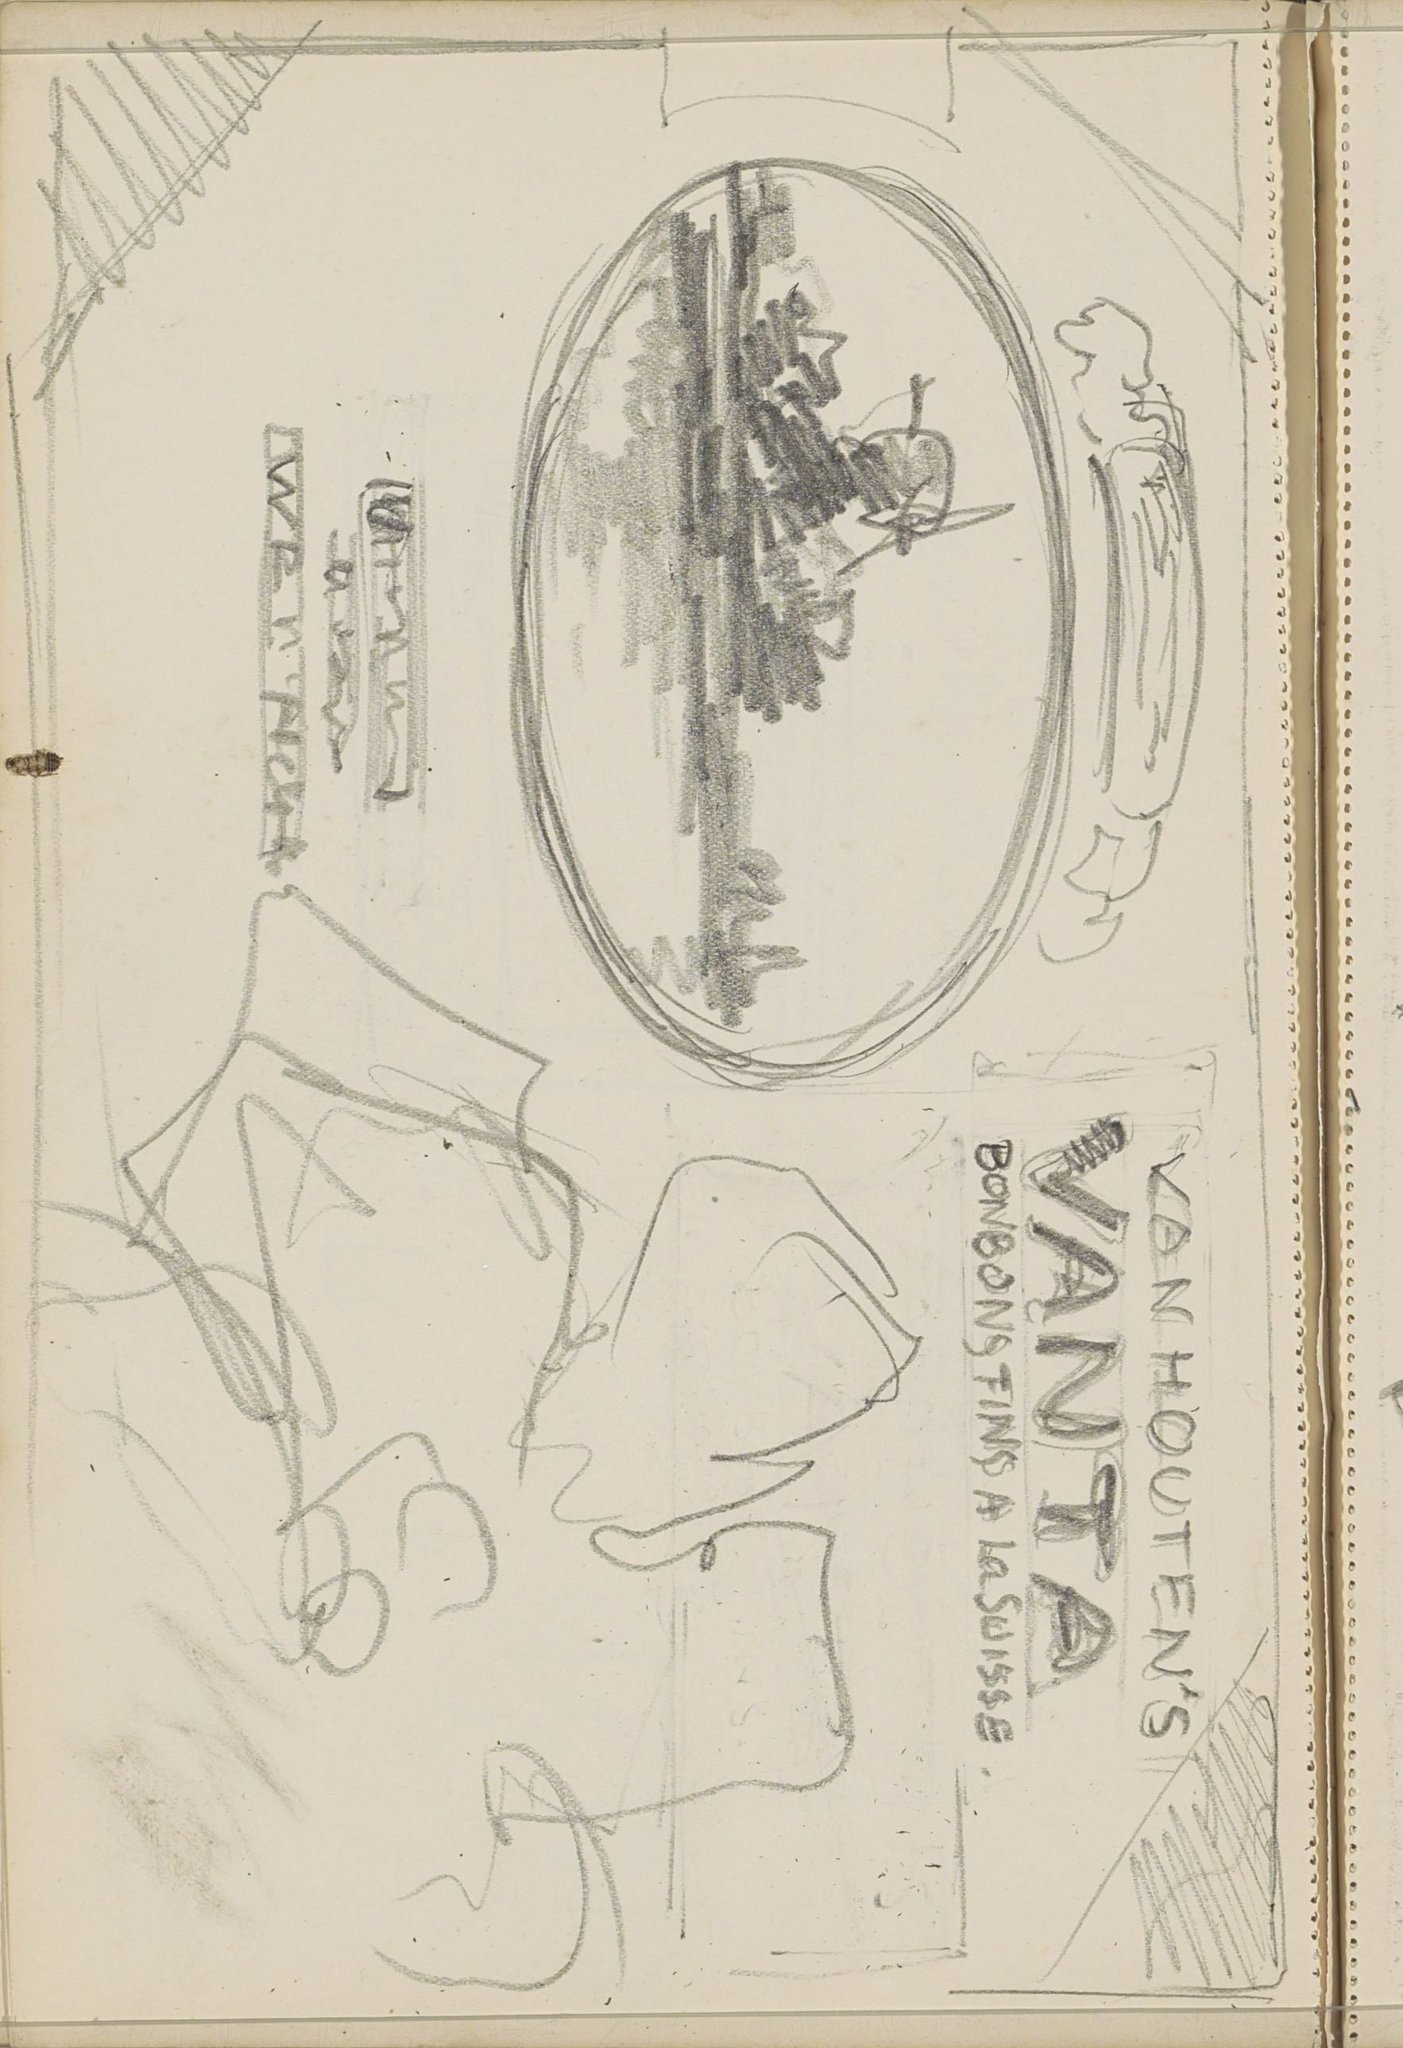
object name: sketchbook leaf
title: Ontwerp voor een bonbonblik van de firma Van Houten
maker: cornelis vreedenburgh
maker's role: draughtsman, print maker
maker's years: 1880-1946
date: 1890-1946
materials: paper, pencil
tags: containers, windmill in landscape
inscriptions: annotation: ‘VAN HOUTEN'S/ VANTA/ BONBONS A LA SUISSE’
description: Het blik toont in een ovaal een voorstelling van een molen aan het water. Blad 43 verso uit een schetsboek met 59 bladen.